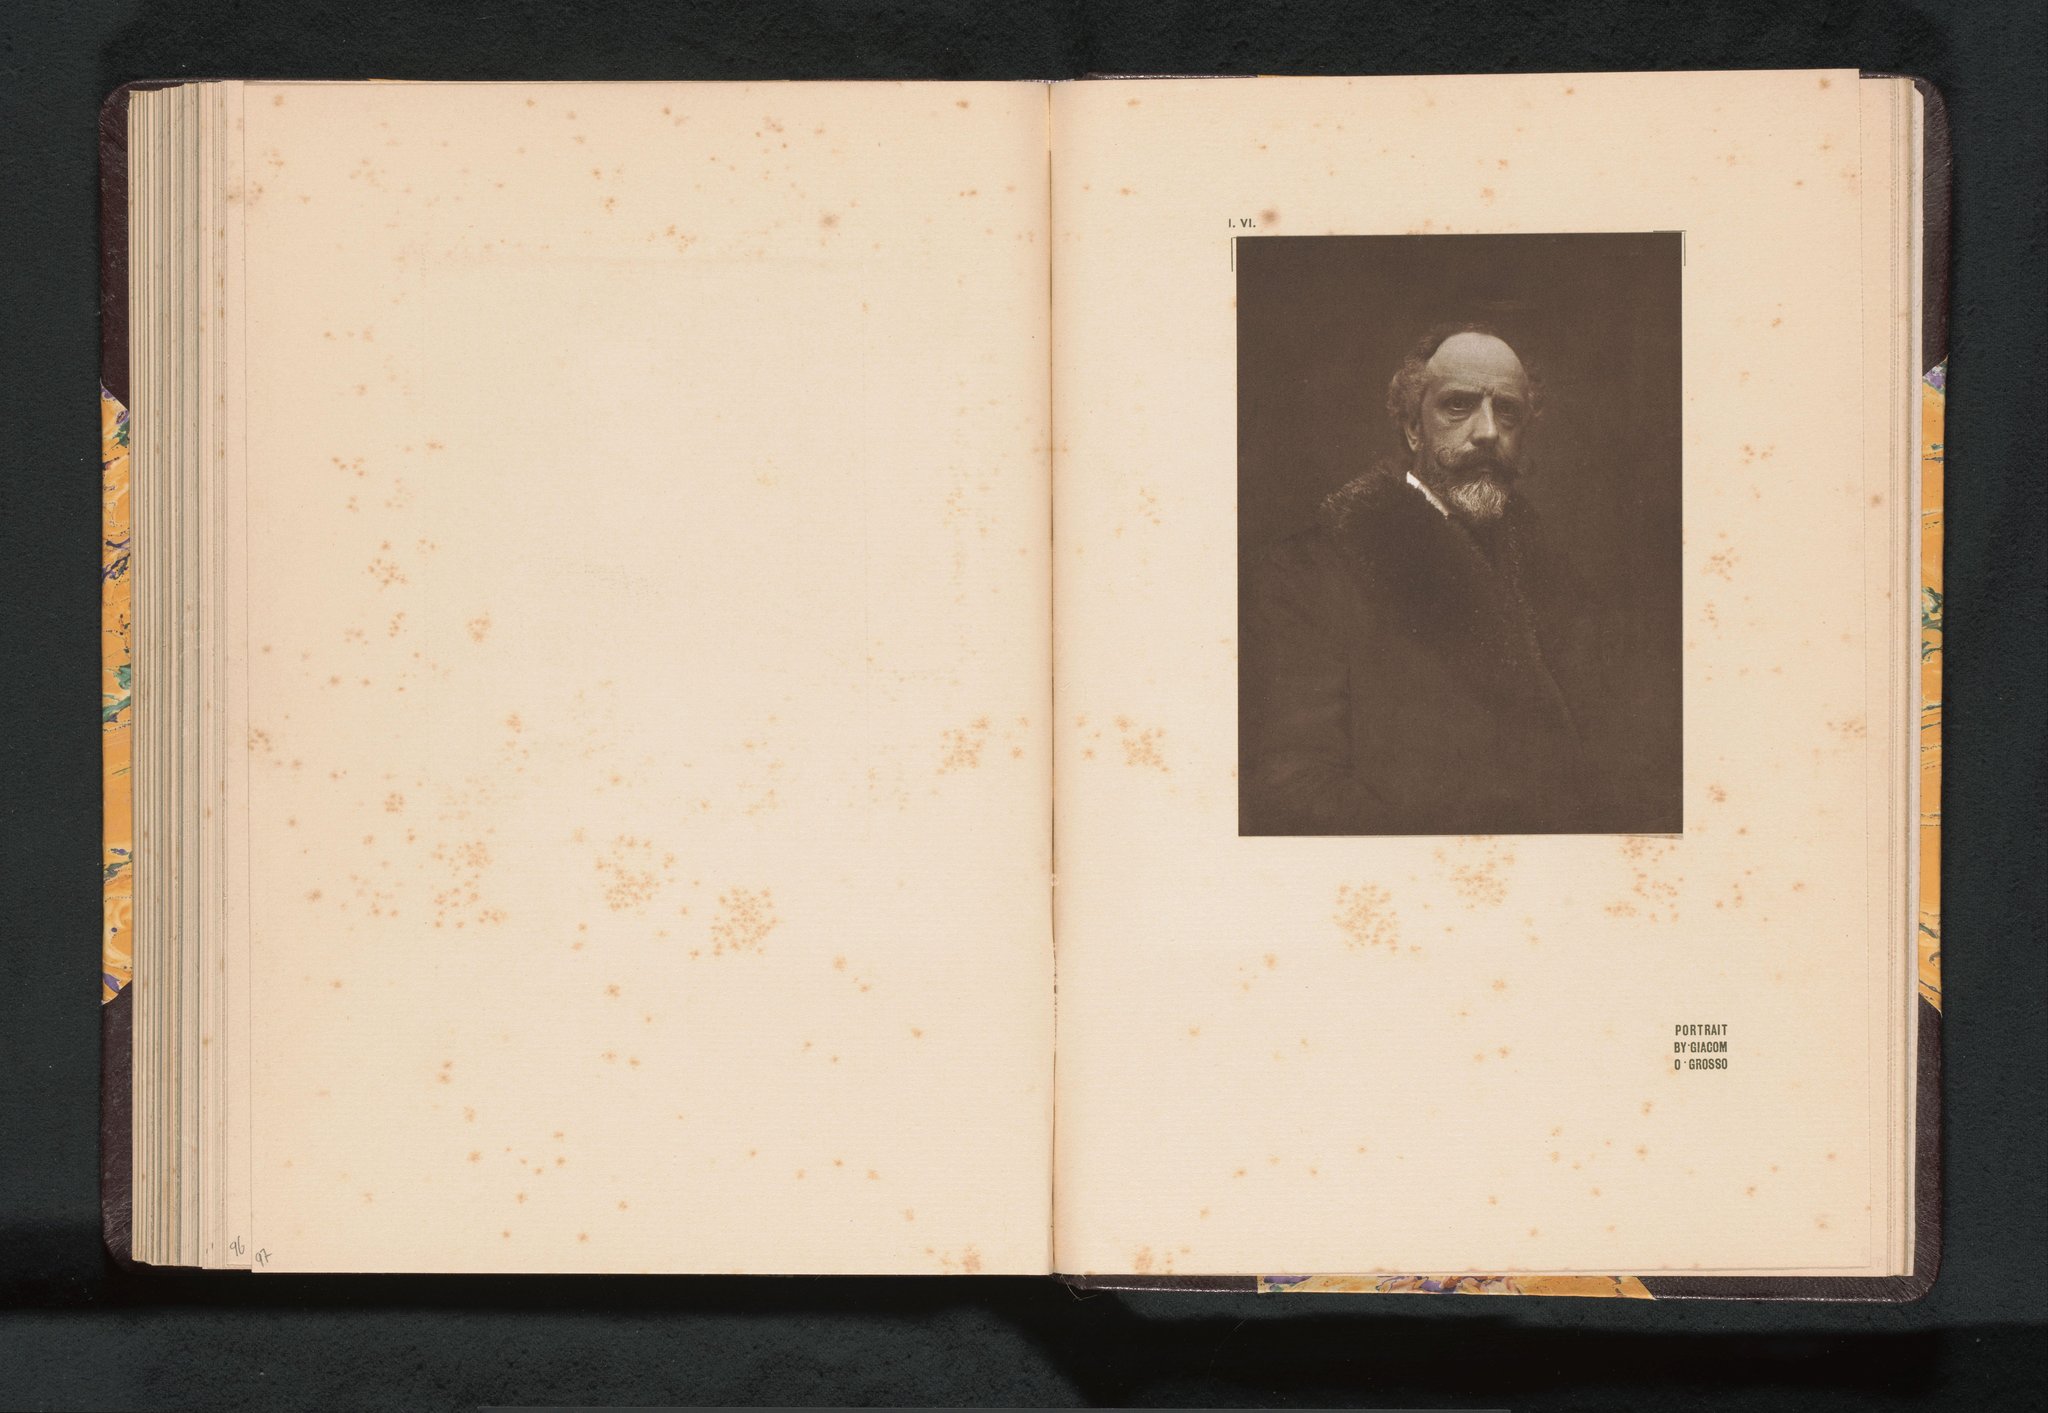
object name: page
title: Portret van een onbekende man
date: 1900-1905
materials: paper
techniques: two-color autotype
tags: historical persons, old man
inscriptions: inscription: ‘I. VI.’, inscription: ‘Portrait by Giacomo Grosso’